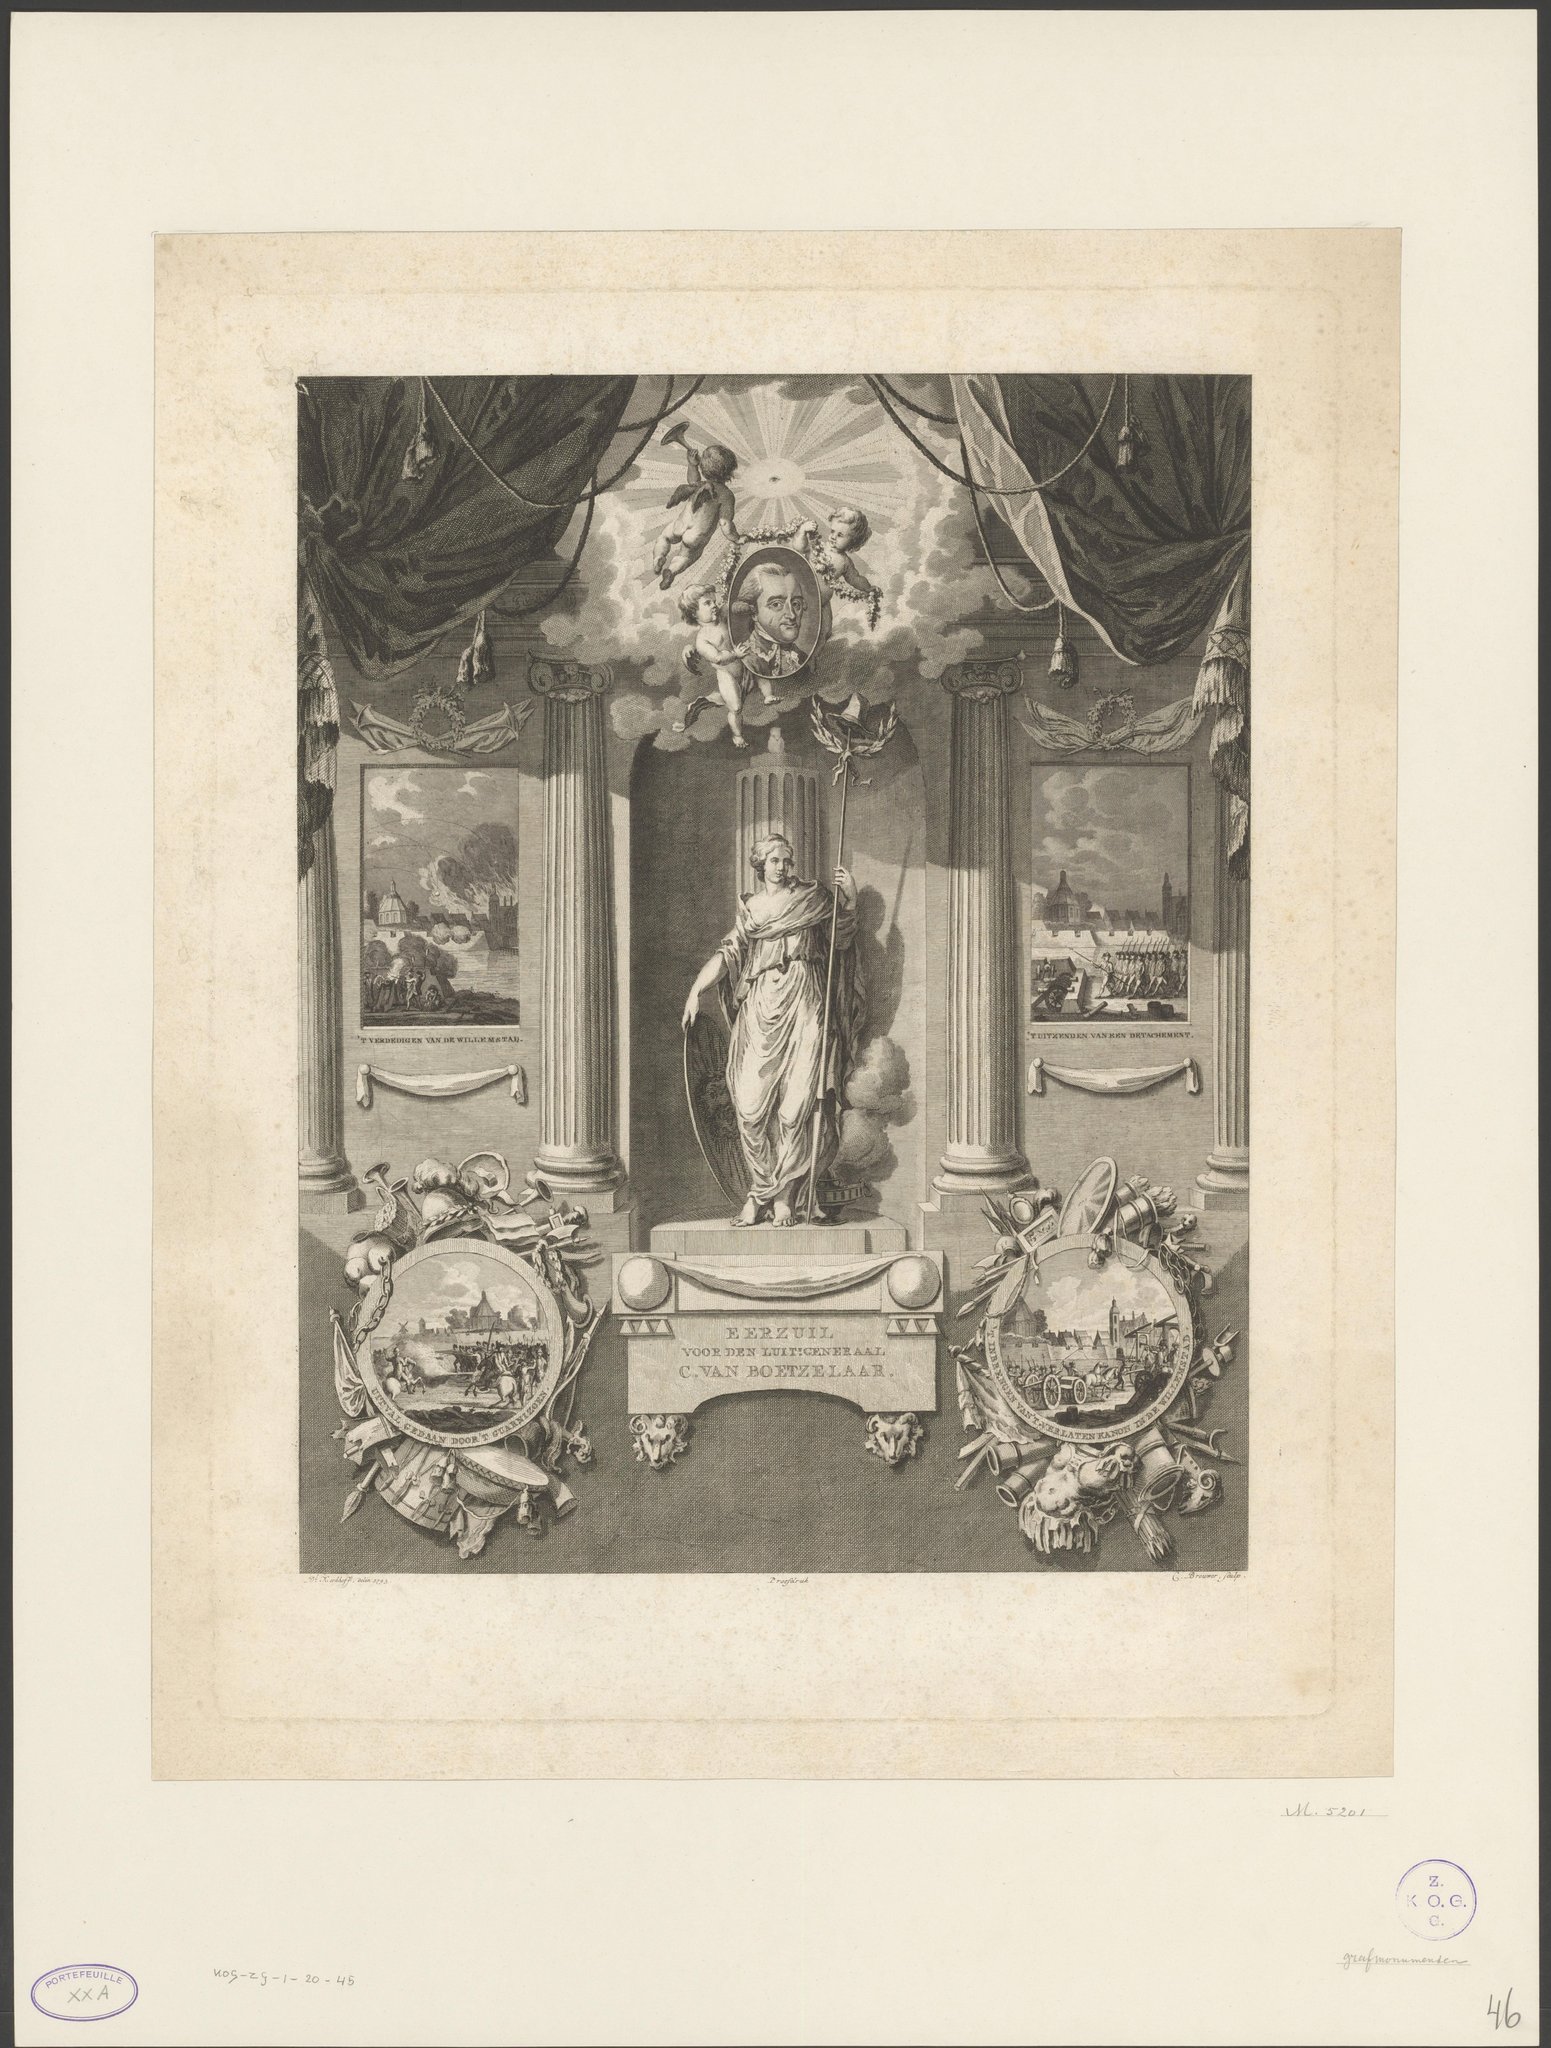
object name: print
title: Erezuil voor luitenant-generaal Carel Baron van Boetzelaer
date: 1793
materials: paper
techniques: engraving, etching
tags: grave, tomb, freedom, liberty; 'libertà' (ripa), siege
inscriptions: collector's mark: Lugt 1641, stamp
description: Erezuil voor luitenant-generaal Carel Baron van Boetzelaer, belast met de verdediging van Willemstad tijdens het beleg door het Franse leger 27 februari - 15 maart 1793. Nis met een standbeeld van de Vrijheid, bovenaan putti met een portret van de baron. Links en rechts vier voorstellingen van gebeurtenissen tijdens het beleg. Onderwerpsrubrieken binnen de Atlas Zeden en Gewoonten: Zeden en Gewoonten in Engeren Zin, Des menschen beging, midden en einde, Grafmonumenten.